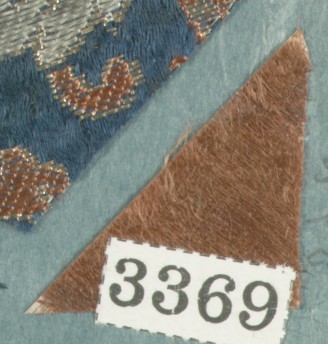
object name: textile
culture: japanese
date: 1801-1900